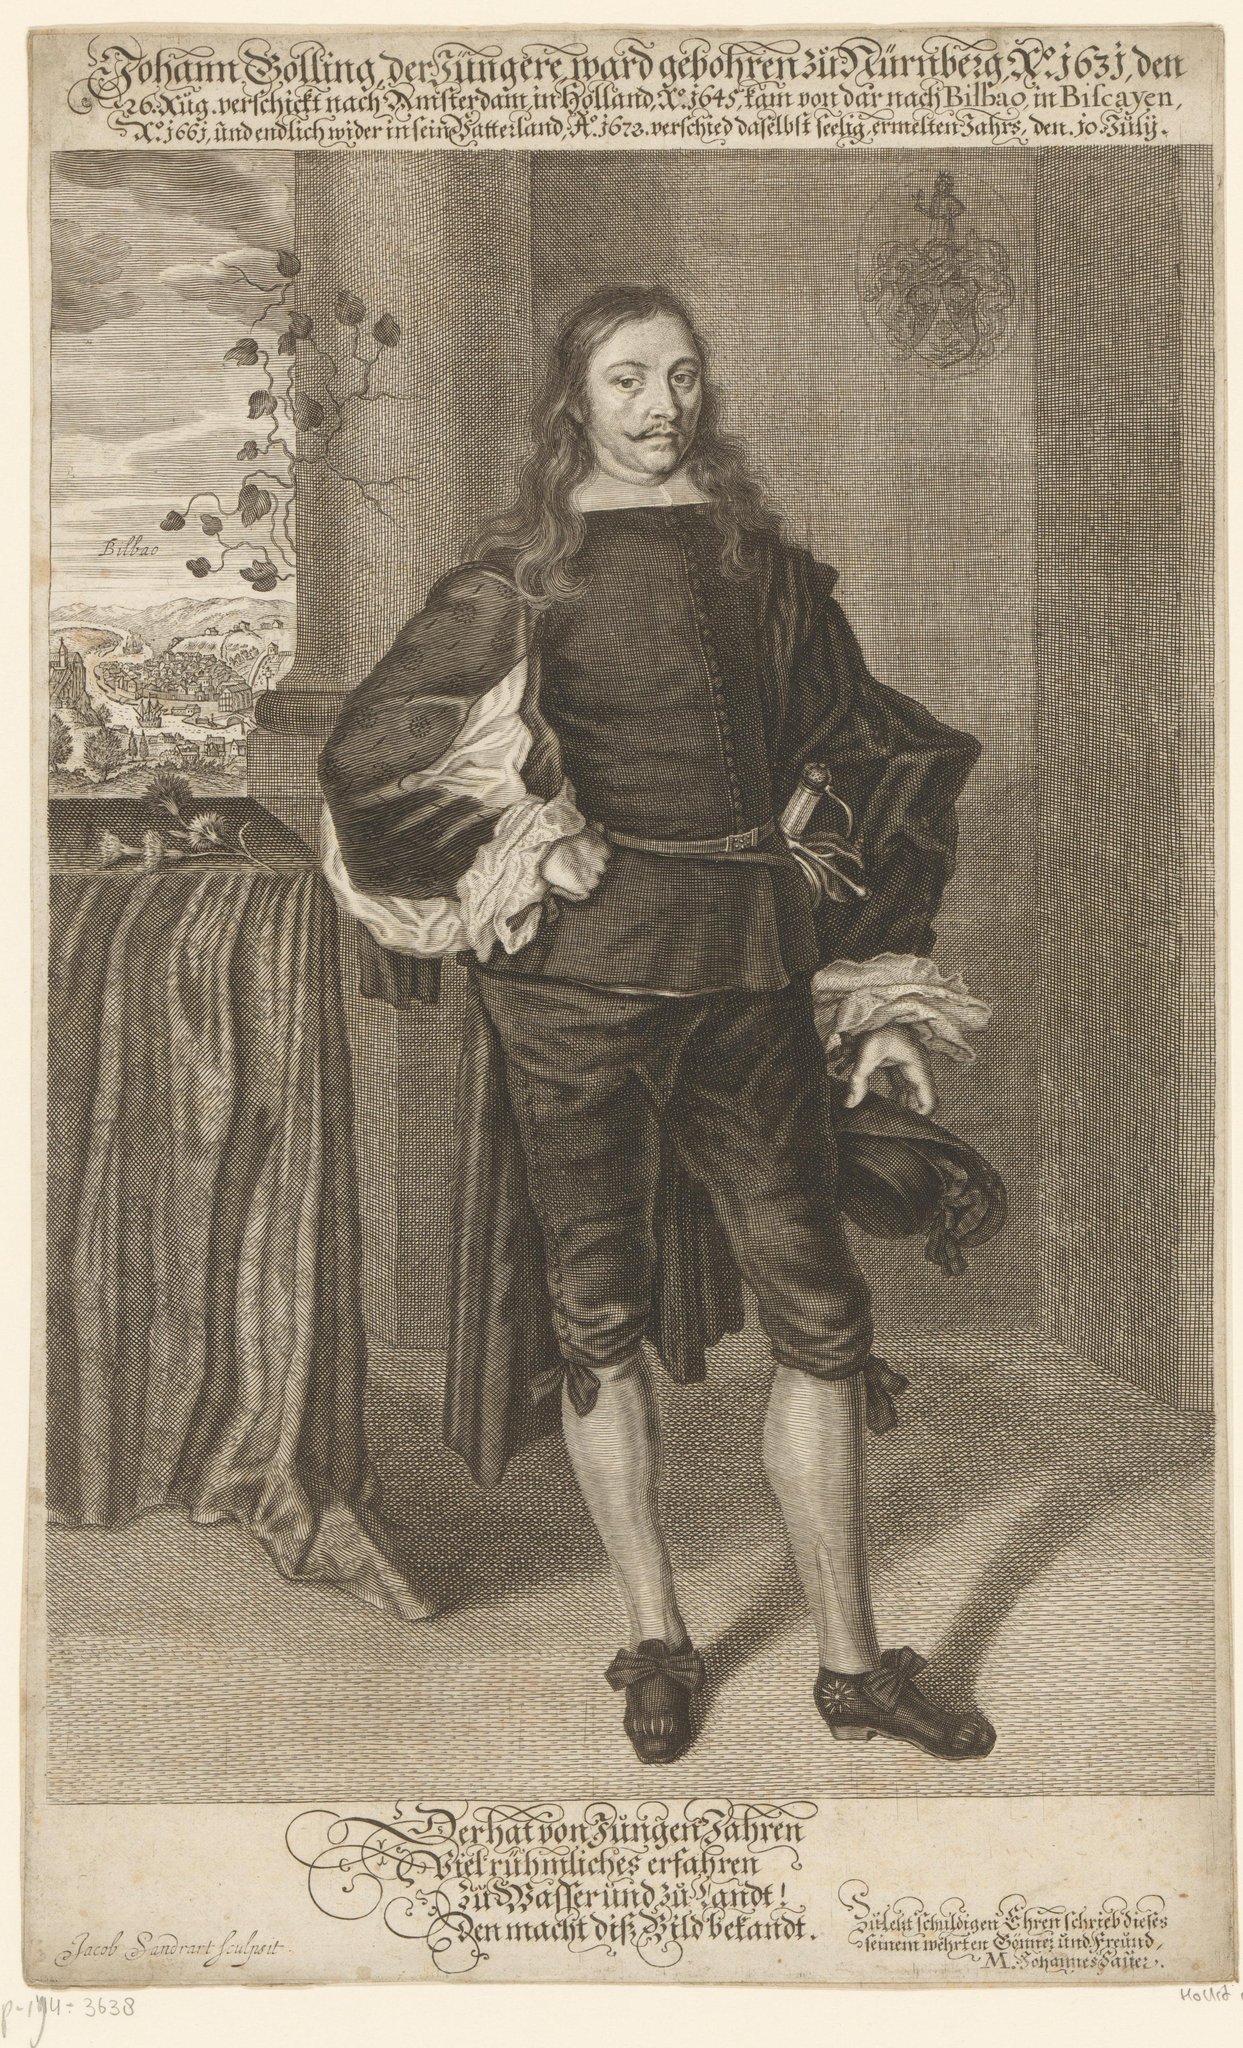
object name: print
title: Portret van Johann Golling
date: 1673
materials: paper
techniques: engraving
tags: flowers, city-view, and landscape with man-made constructions, historical persons, armorial bearing, heraldry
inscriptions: collector's mark: Lugt 2228